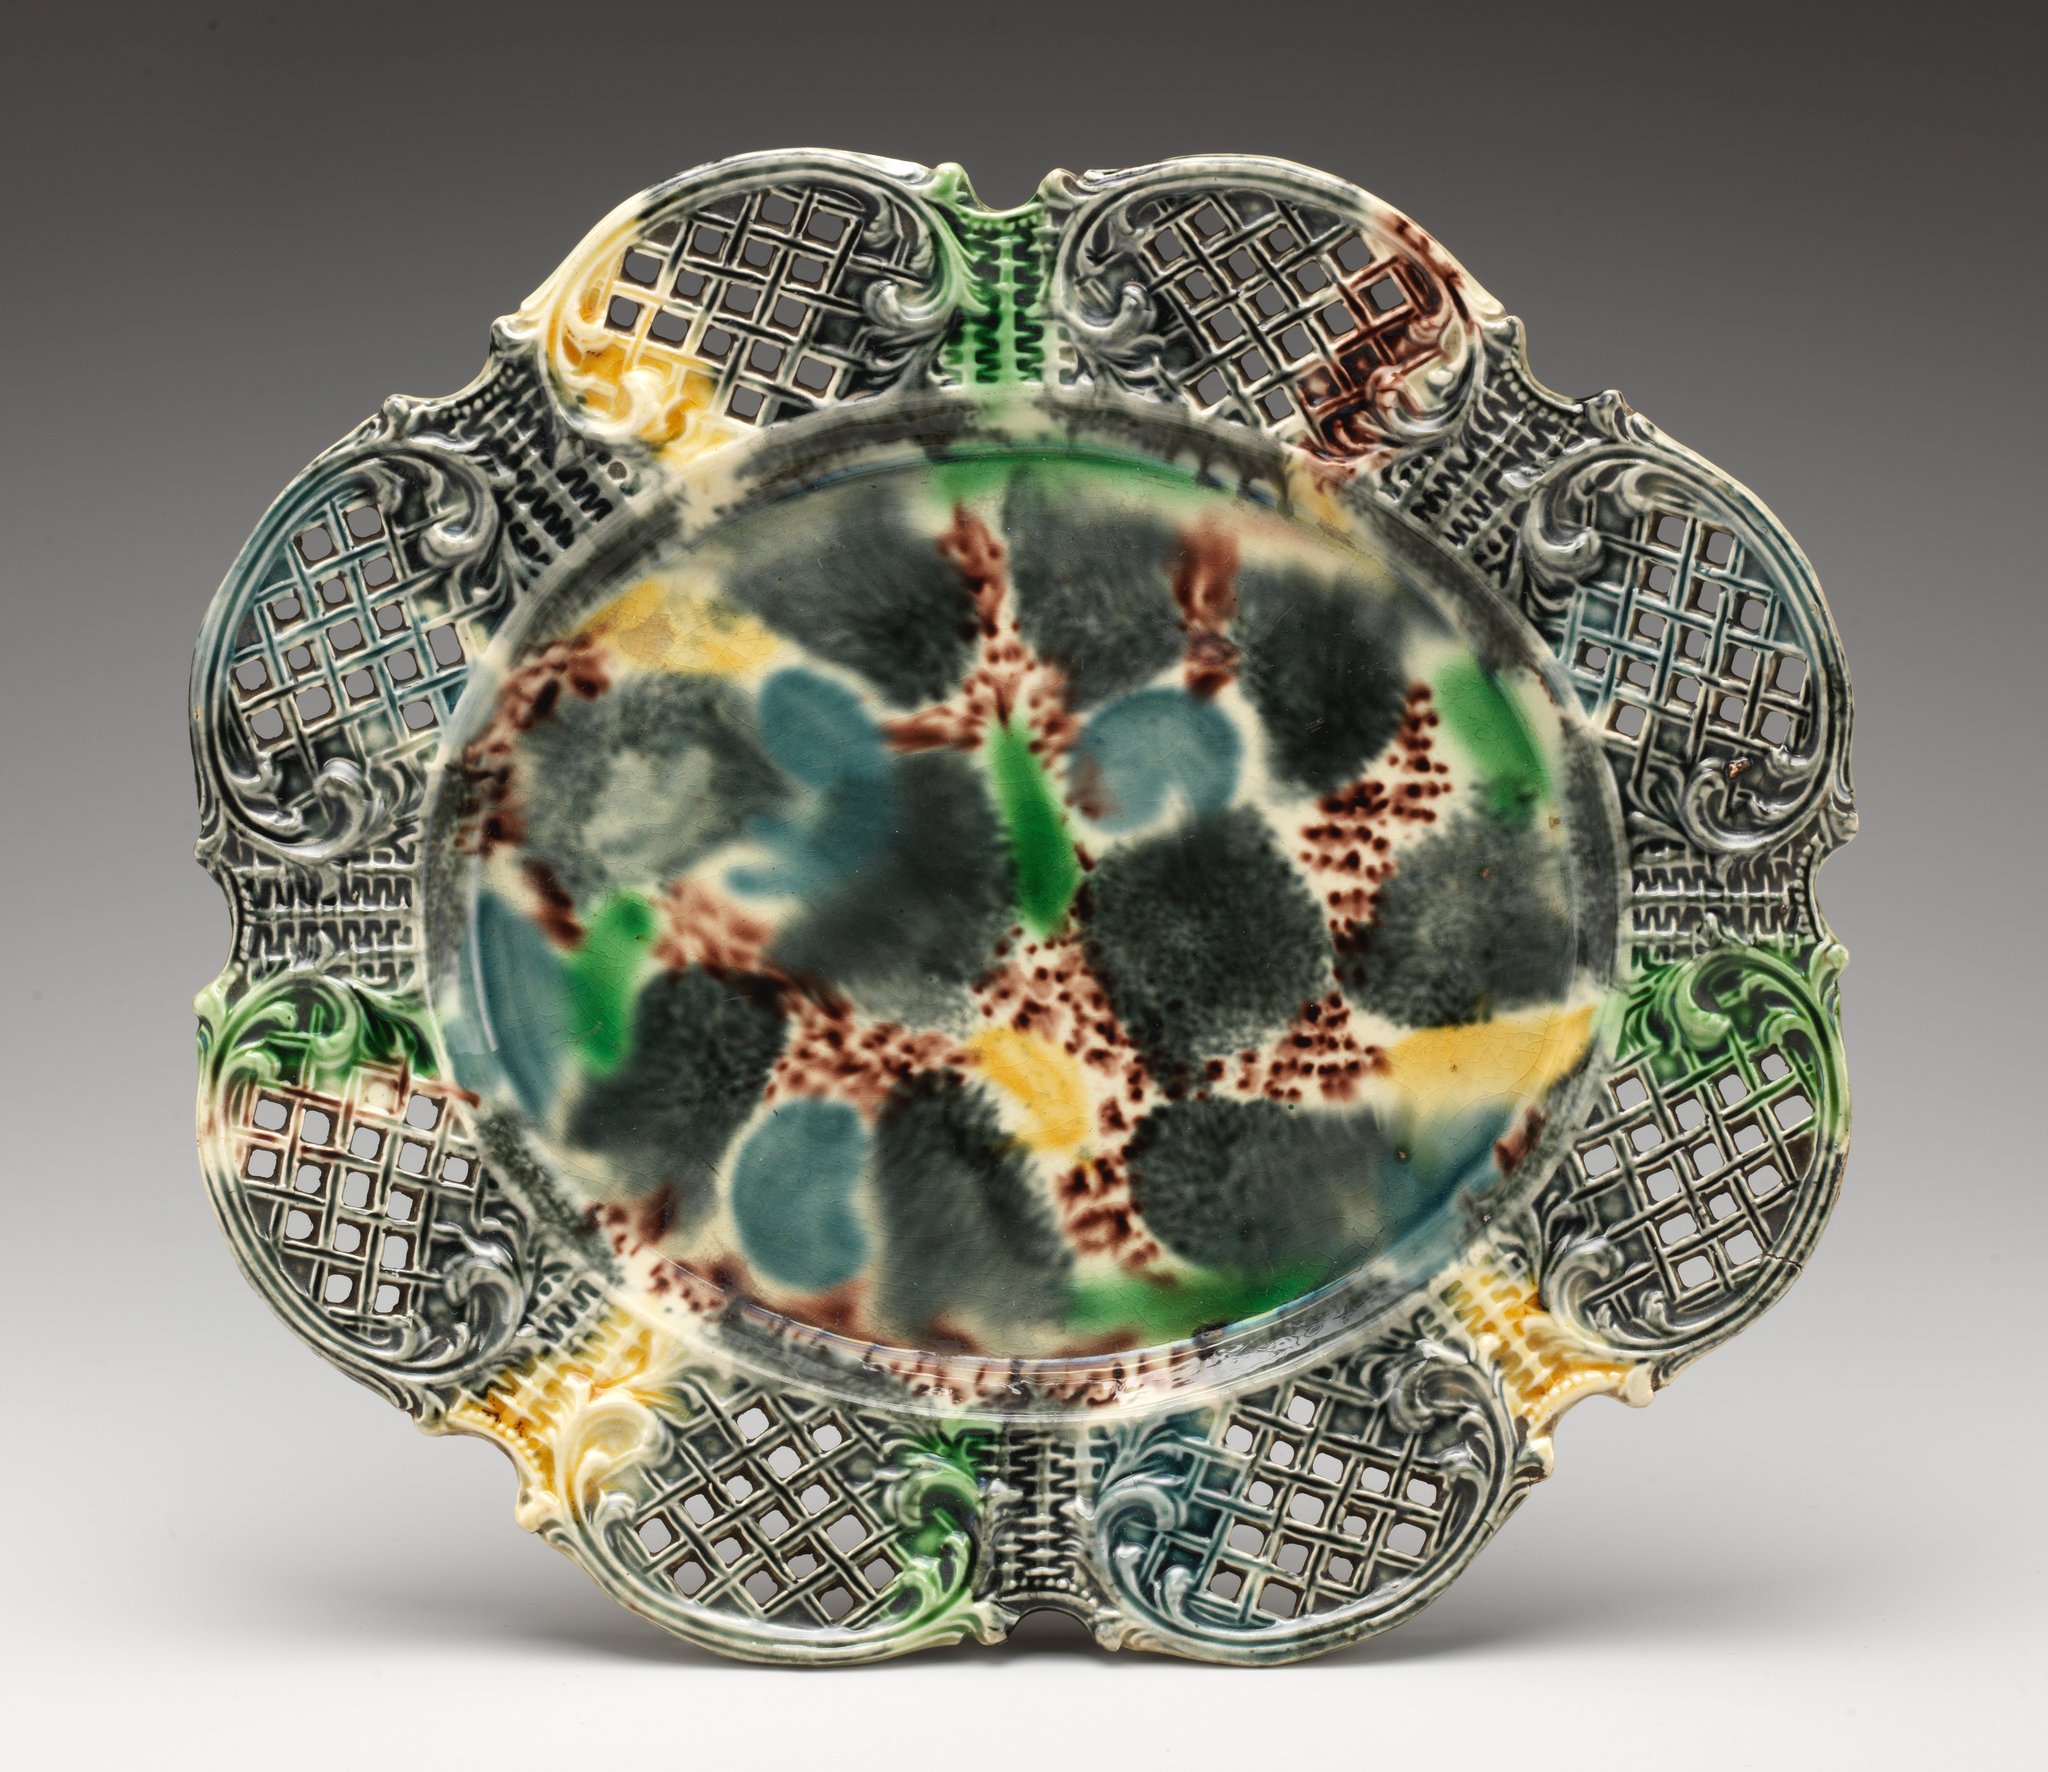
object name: stand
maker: whieldon type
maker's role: maker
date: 1760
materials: earthenware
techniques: glazing